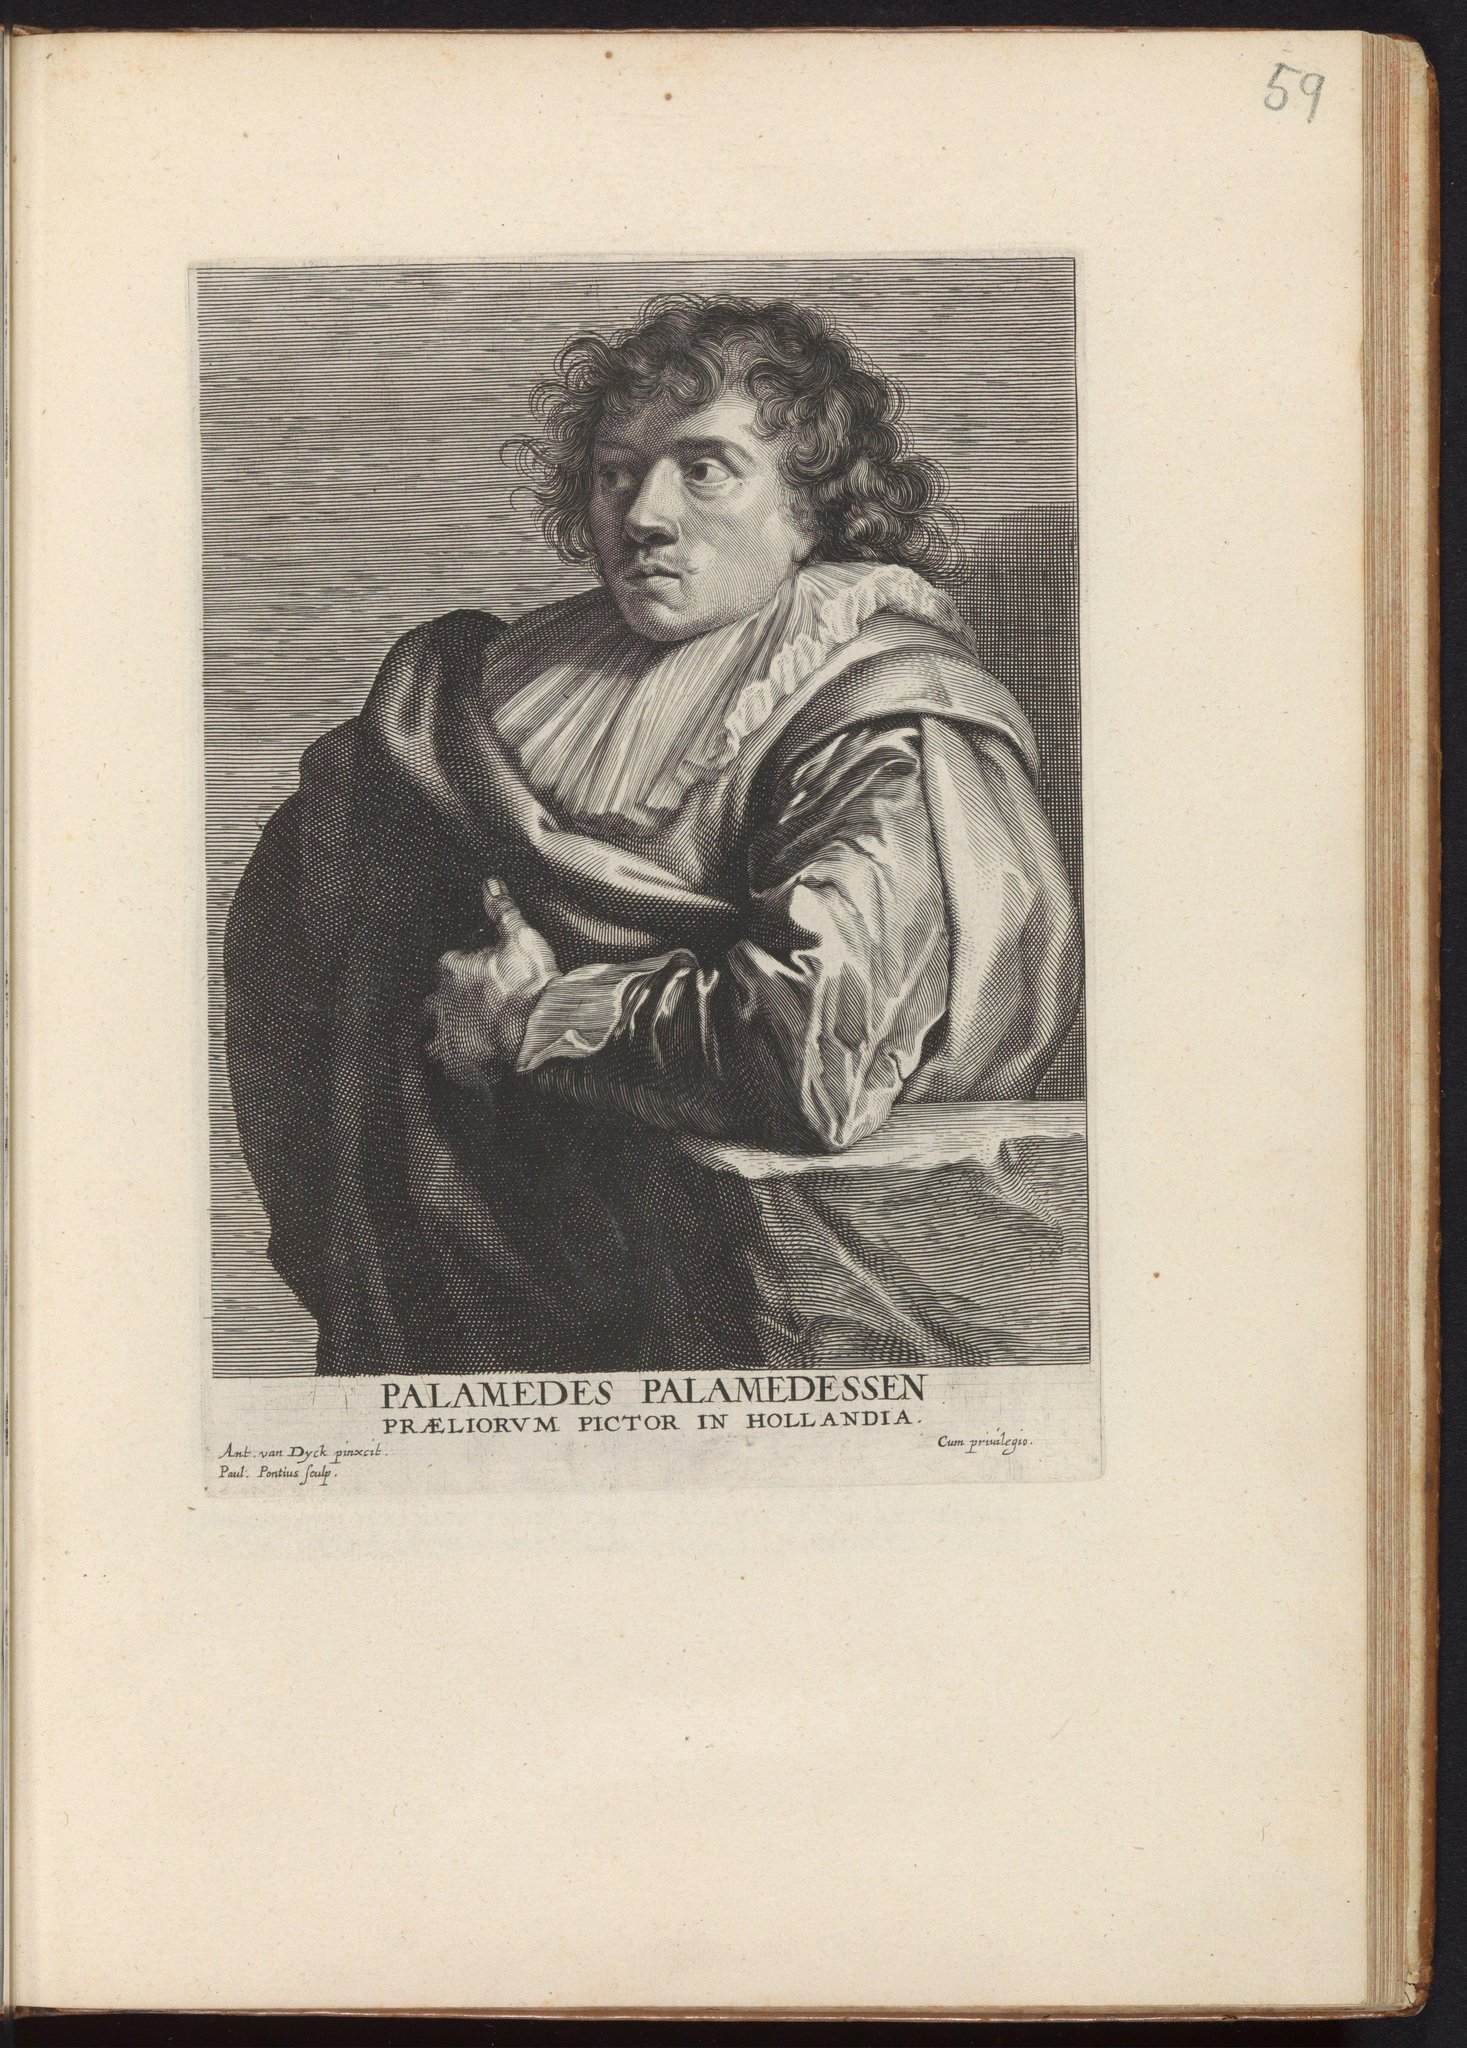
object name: album leaf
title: Portret van Palamedes Palamedesz. I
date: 1630-1641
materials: paper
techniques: engraving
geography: antwerp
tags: delft, painter, palamedes palamedesz. (i), historical persons, portrait, self-portrait of painter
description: Deze prent maakt deel uit van een album.